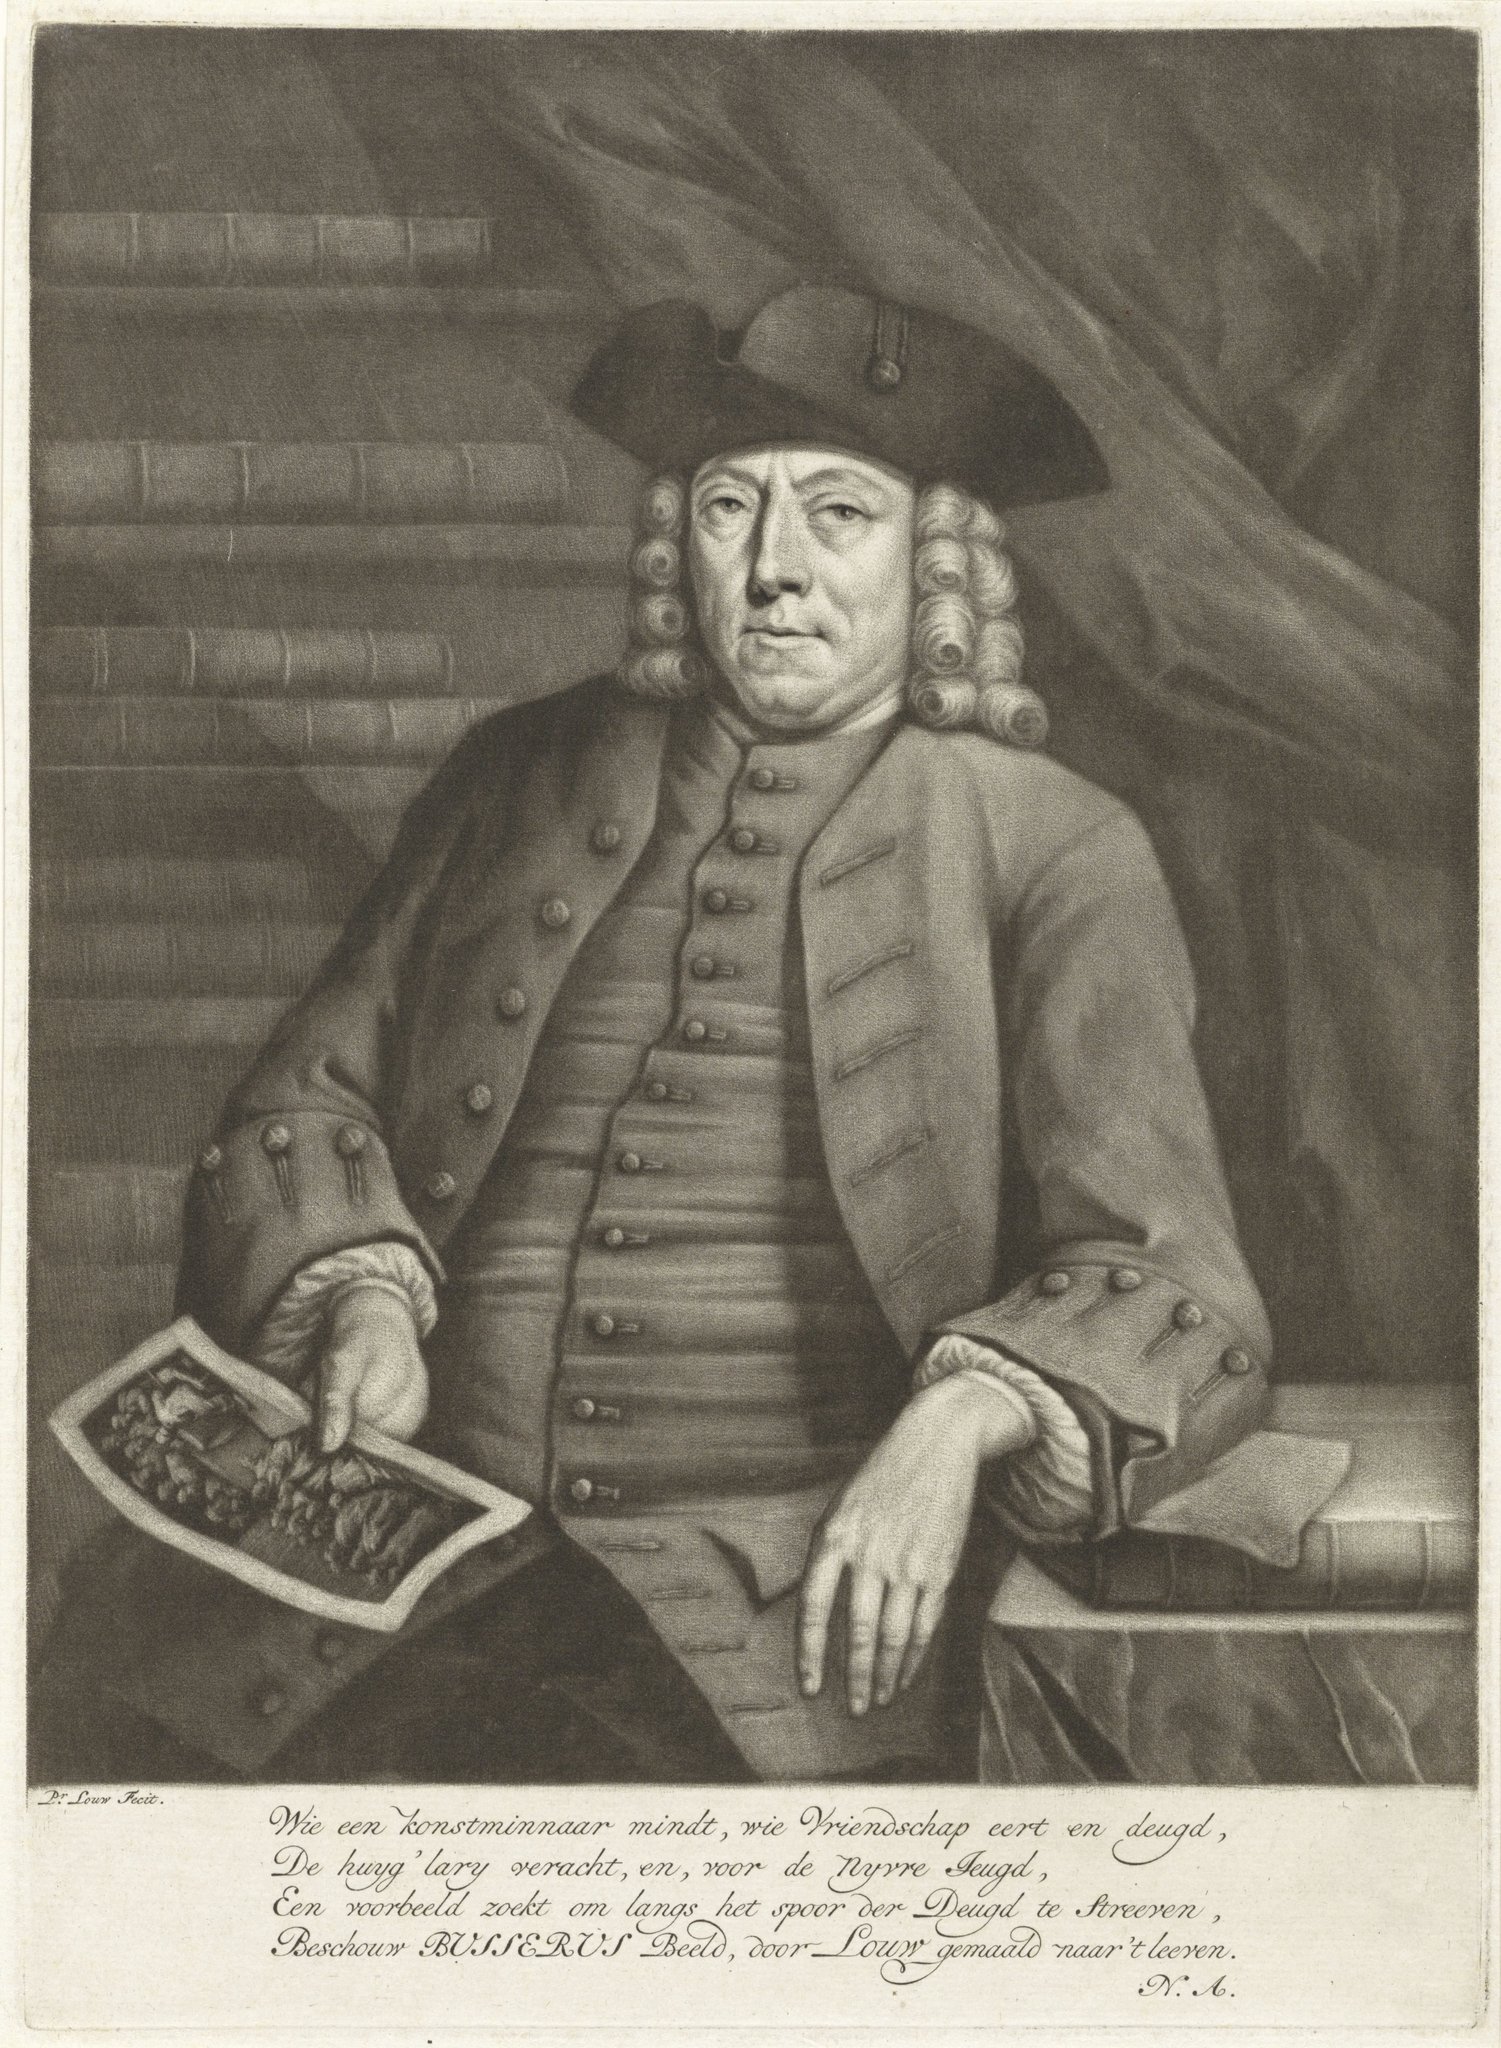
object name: print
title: Portret van Hendrik Busserus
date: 1743-1772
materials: paper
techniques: engraving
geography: amsterdam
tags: amsterdam, print maker, hendrik busserus, christ's dispute with the doctors in the temple; he counts his arguments on his fingers, person stimulating the arts; art lover, connoisseur, maecenas, patron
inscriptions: collector's mark: Lugt 2760, collector's mark: Lugt 2228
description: De kunstverzamelaar en graveur Hendrik Busserus met in de hand een prent door Rembrandt Harmensz. van Rijn en Pieter Louw met 'Christus in de tempel'. Busserus zit naast een tafel voor een geopende kunstkast. In de marge een vier regelig gedicht over de geportretteerde als voorbeeld voor de jeugd.